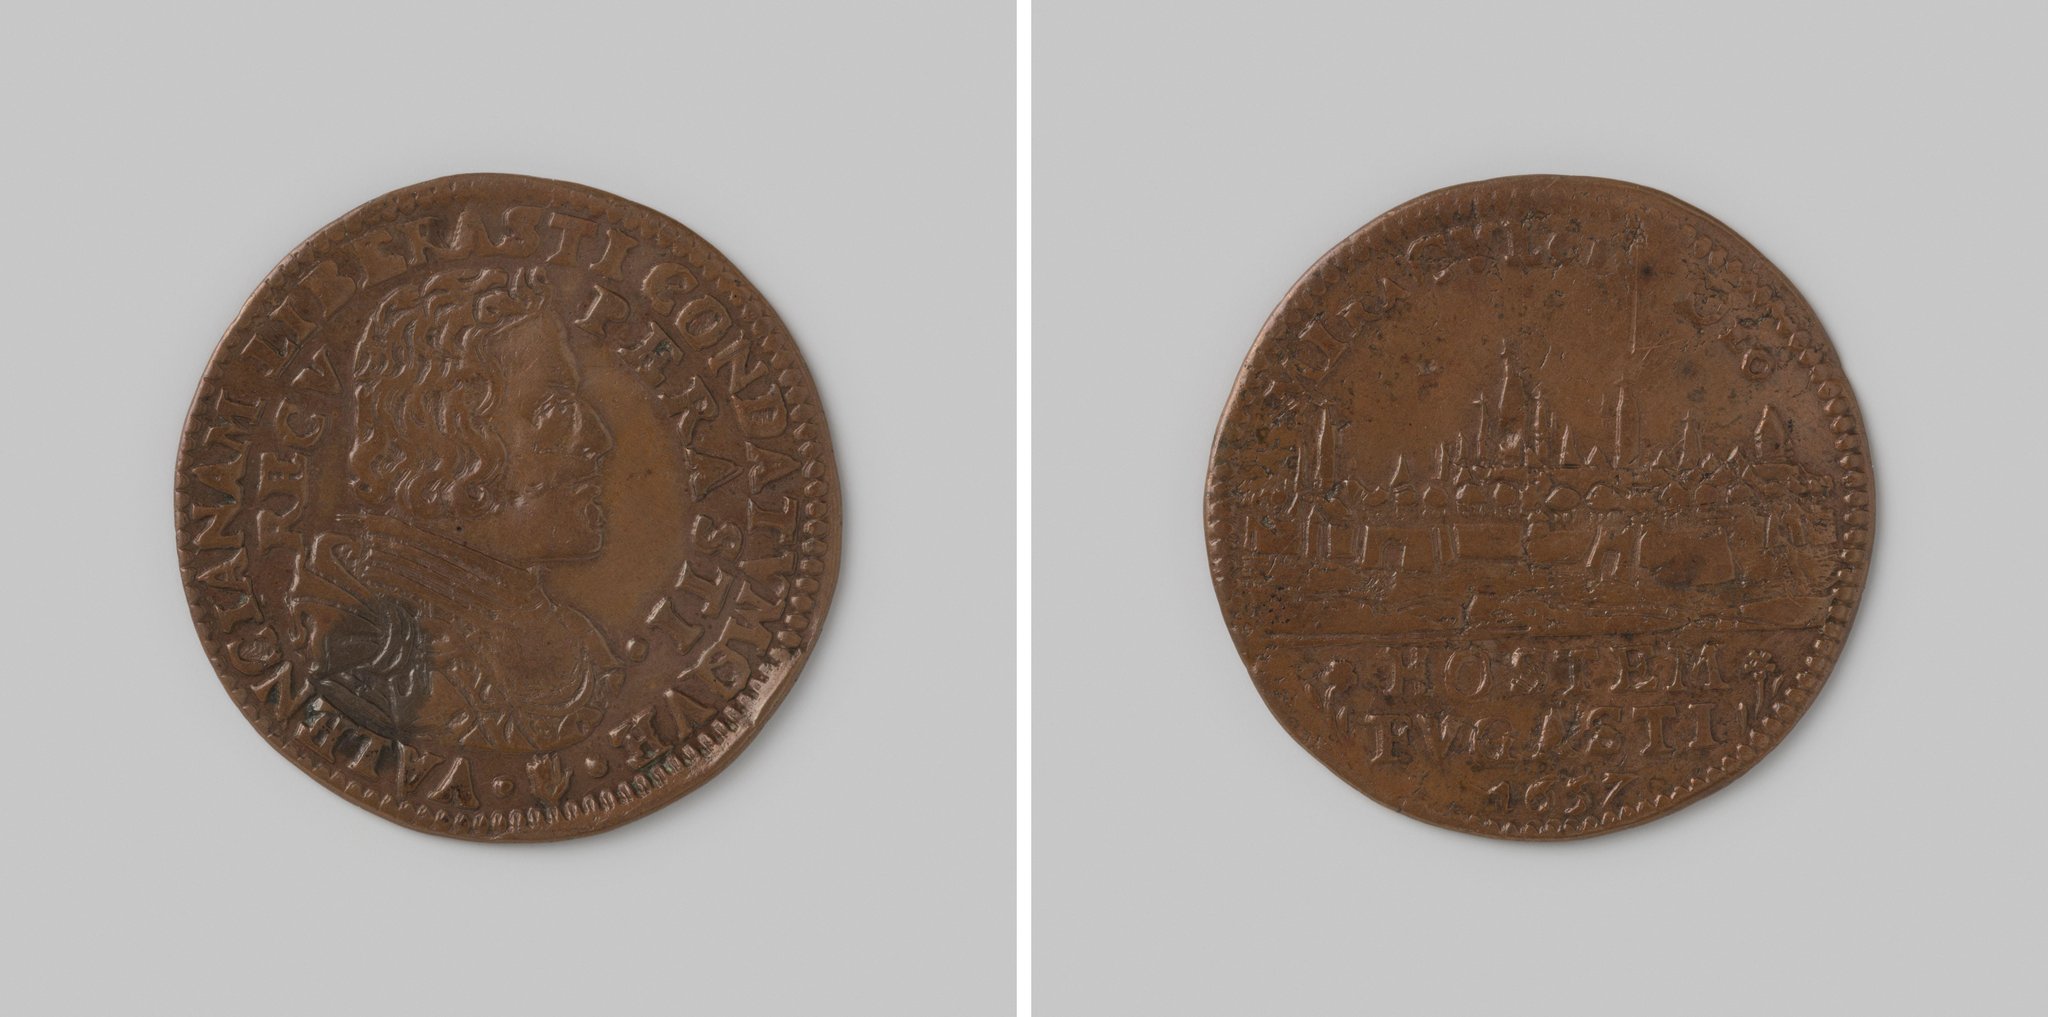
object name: jeton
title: Rekenpenning uit Antwerpen op het ontzet van Valenciennes 1657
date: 1657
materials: copper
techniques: striking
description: Koperen penning, op de voorzijde het borstbeeld van Philips IV naar rechts met dubbel omschrift, op de keerzijde het aanzicht van Valenciennes met omschrift en afsnedetekst.